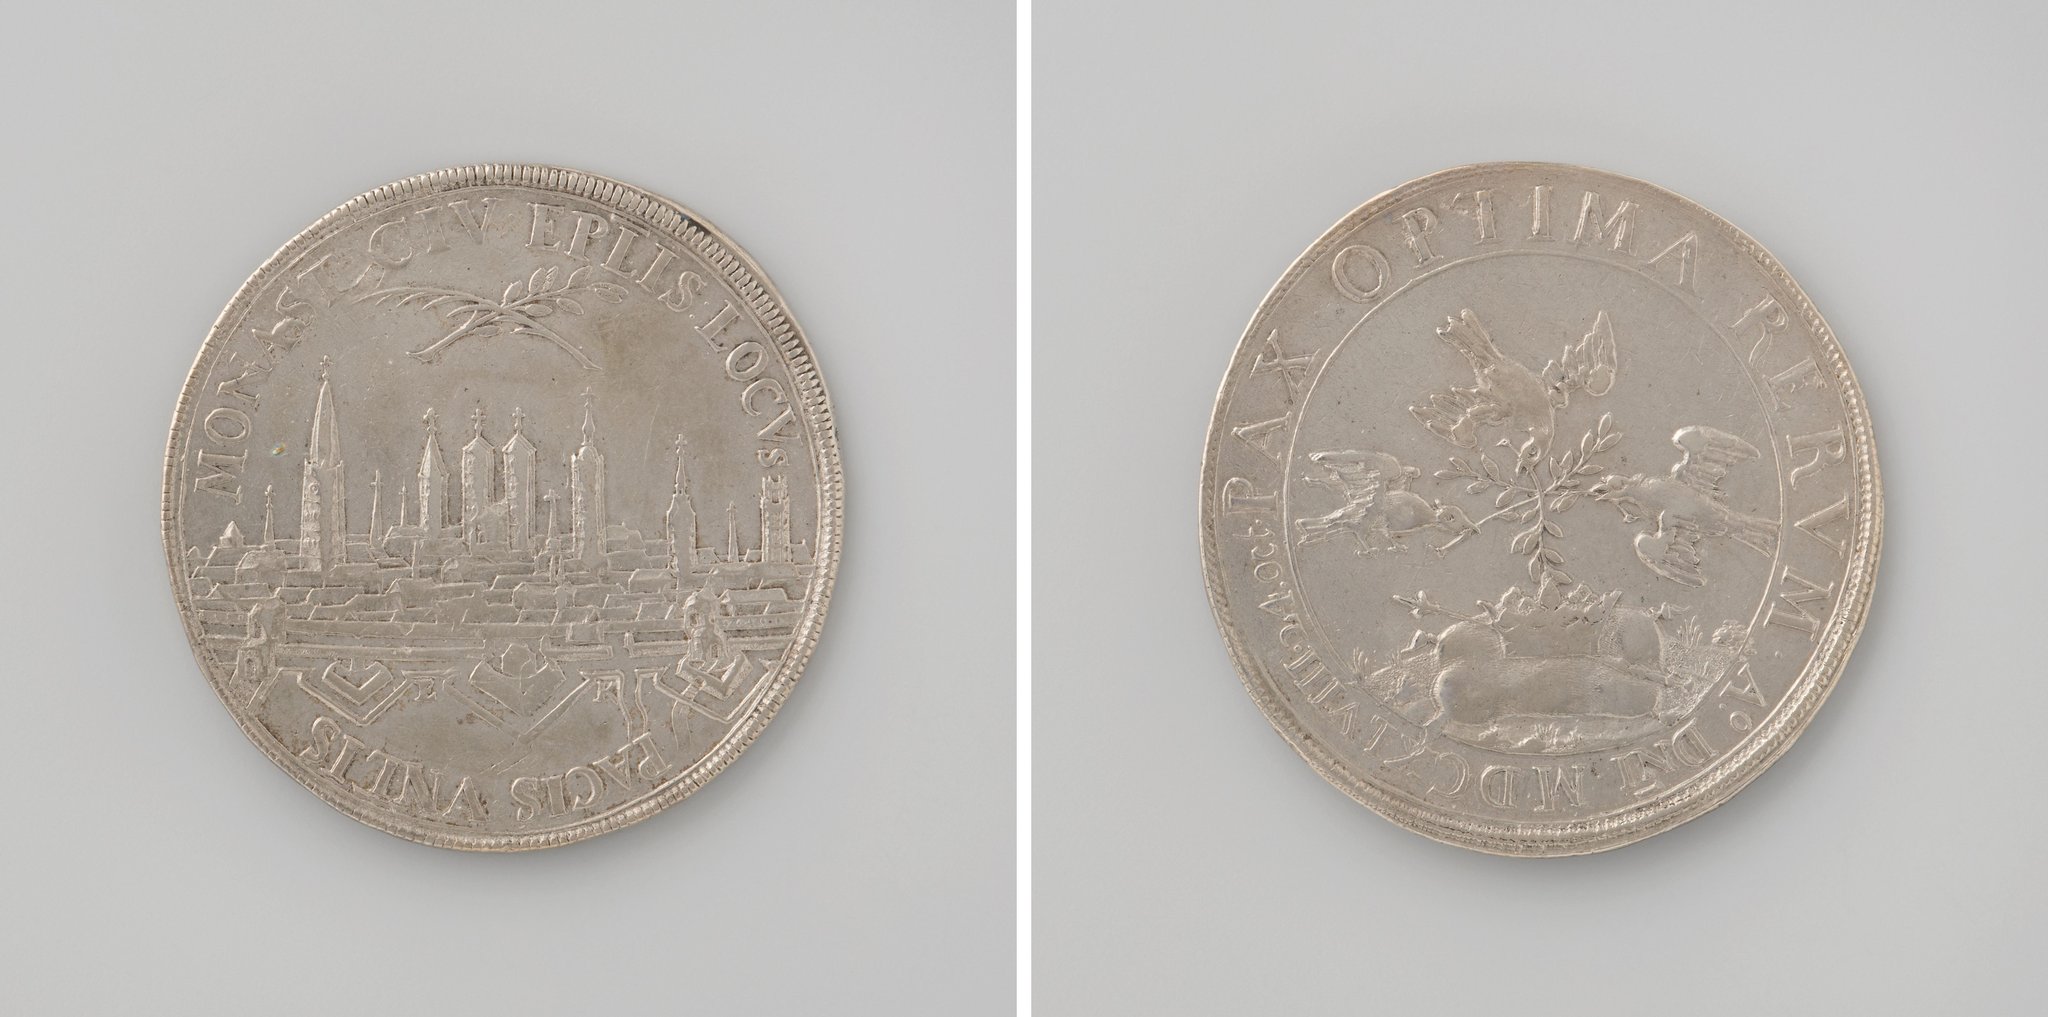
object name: medal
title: Penning over de Vrede van Munster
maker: engelbert kettler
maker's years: 1616-1662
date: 1648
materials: silver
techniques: striking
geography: munster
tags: münster, noordrijn-westfalen, vrede van münster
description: Zilveren penning. Voorzijde: gezicht op stad Munster onder gekruiste palmtak en olijftak binnen omschrift. Keerzijde: drie duiven met vredestakken in de bek boven kroon en scepter op kussen binnen omschrift.